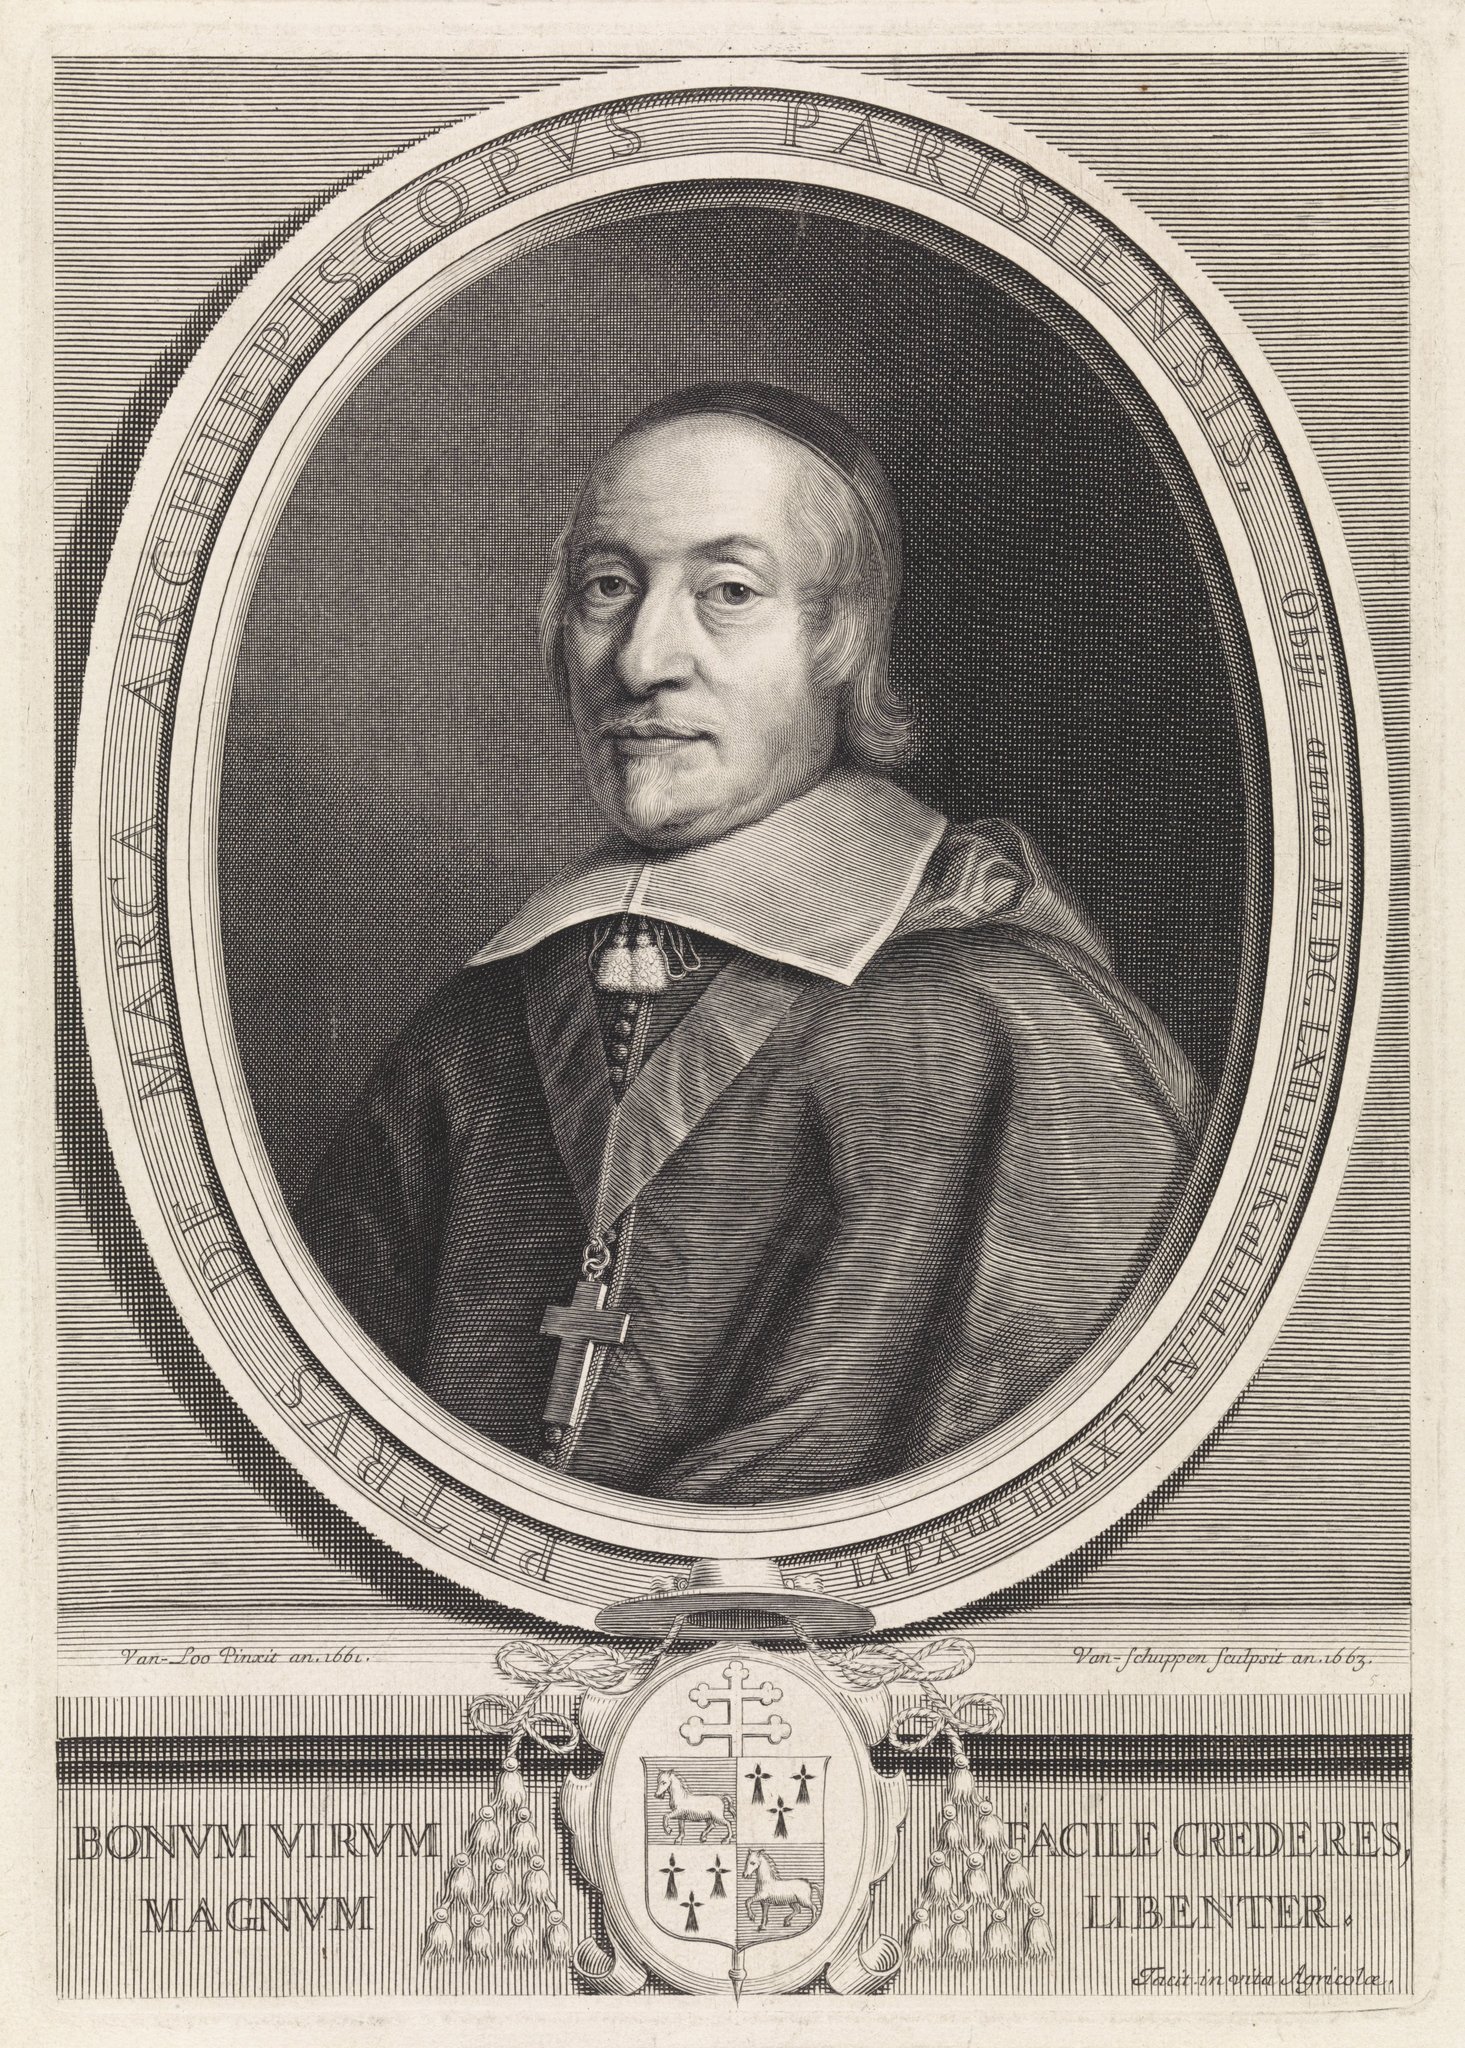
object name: print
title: Portret van bisschop Pierre de Marca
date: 1605-1663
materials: paper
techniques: engraving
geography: paris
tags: bisschop, pierre de marca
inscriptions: collector's mark: Lugt 240